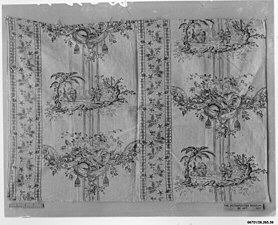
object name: print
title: Striped print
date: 1785-1790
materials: linen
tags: flowers,trees